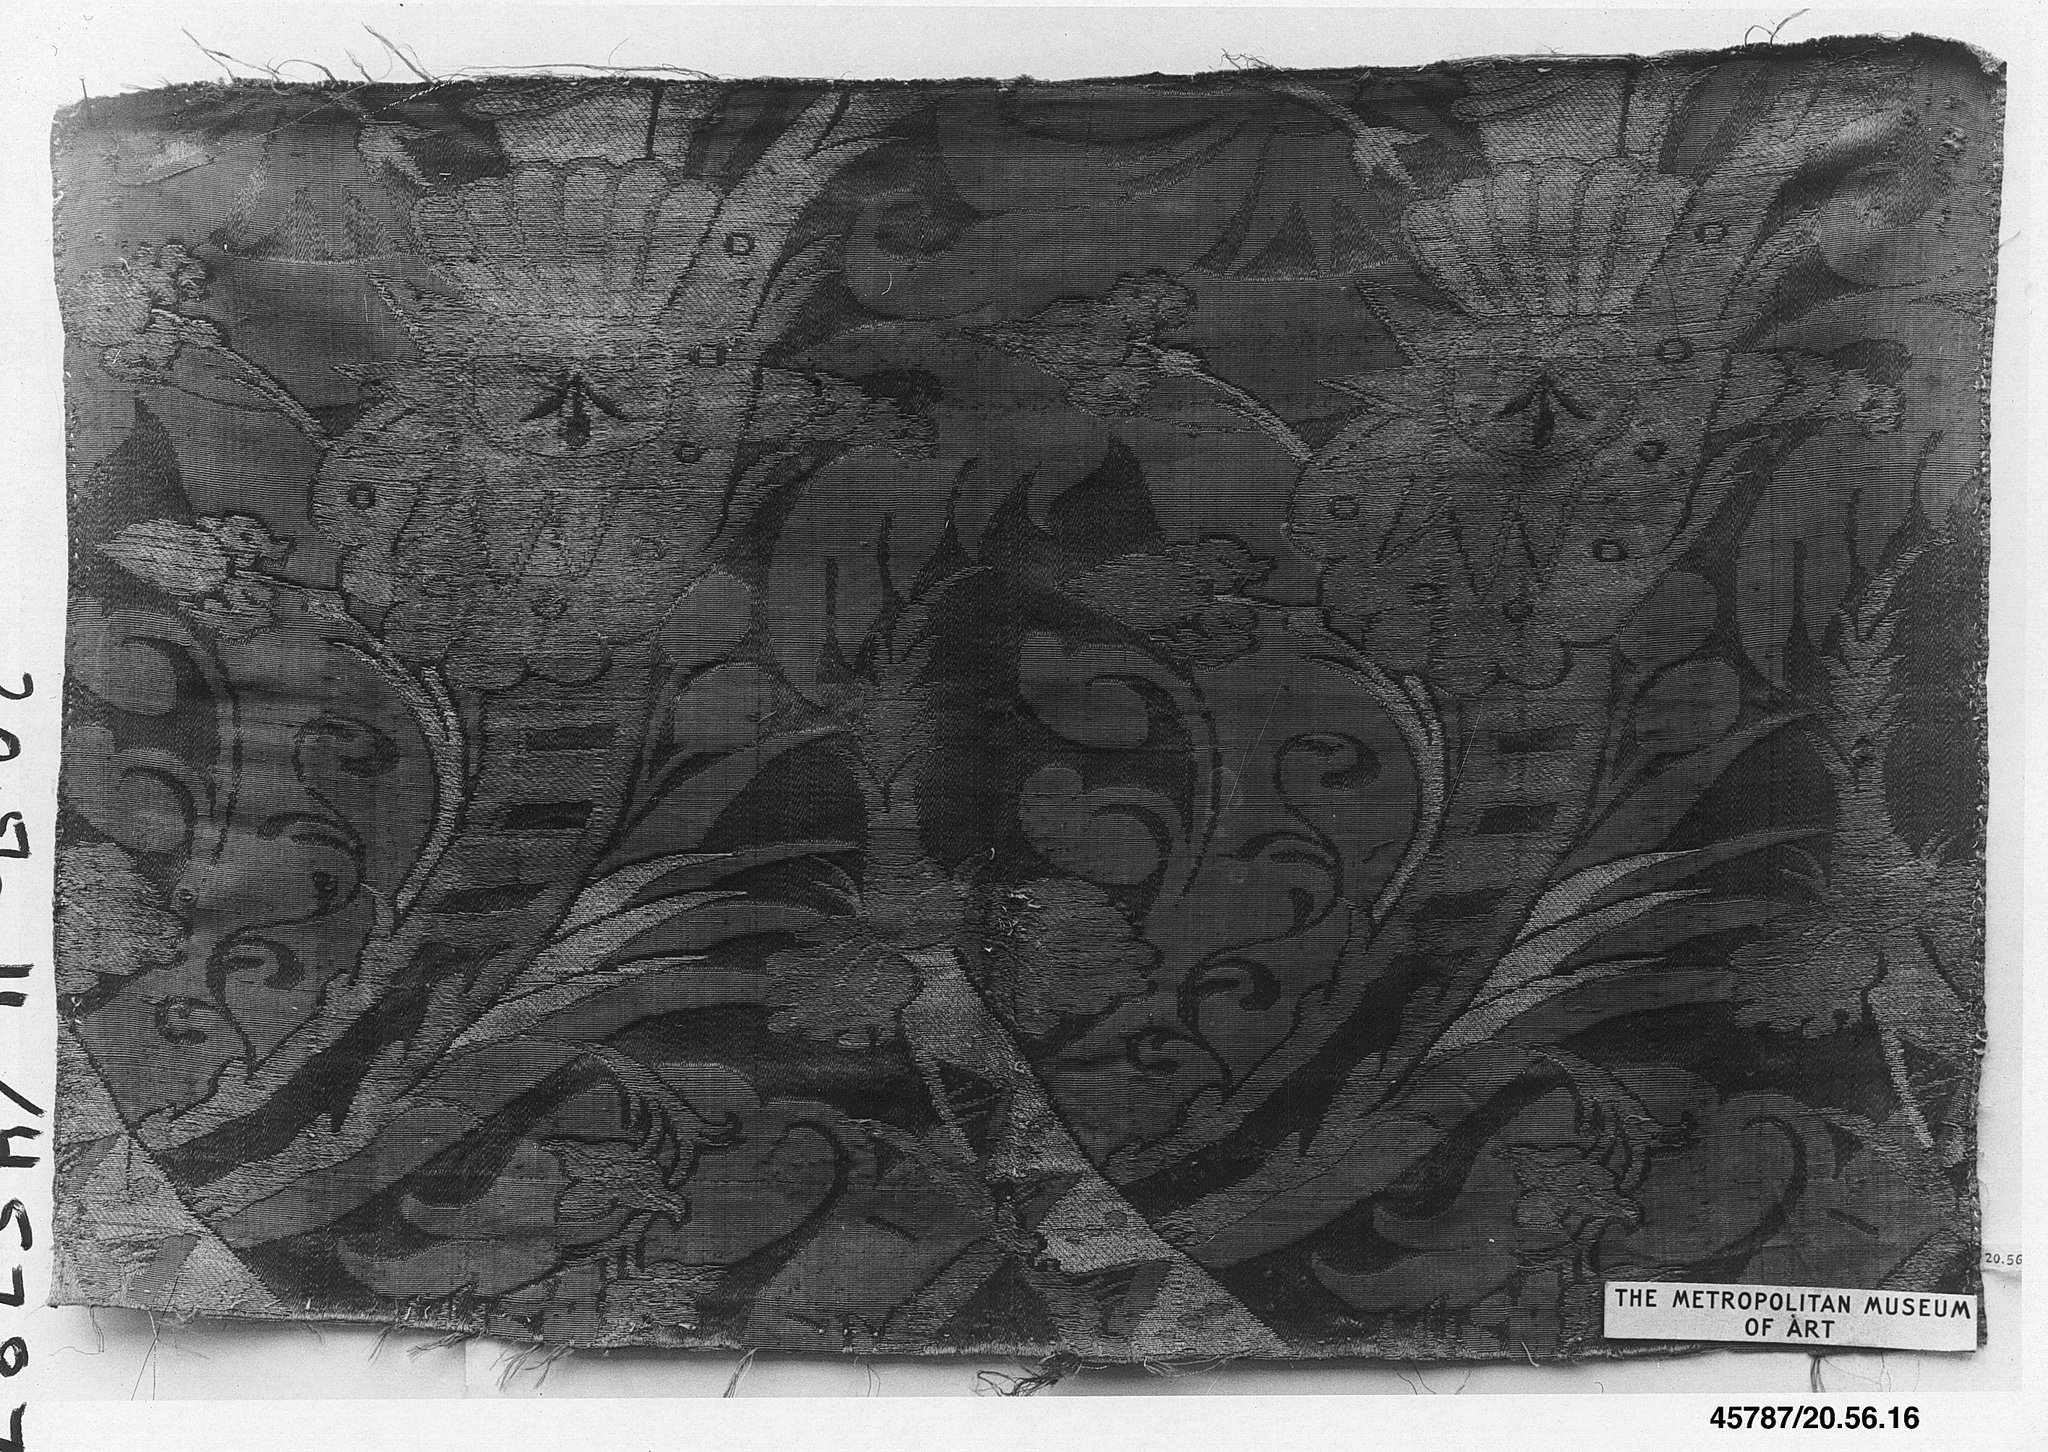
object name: piece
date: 1710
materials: metal thread, silk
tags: leaves